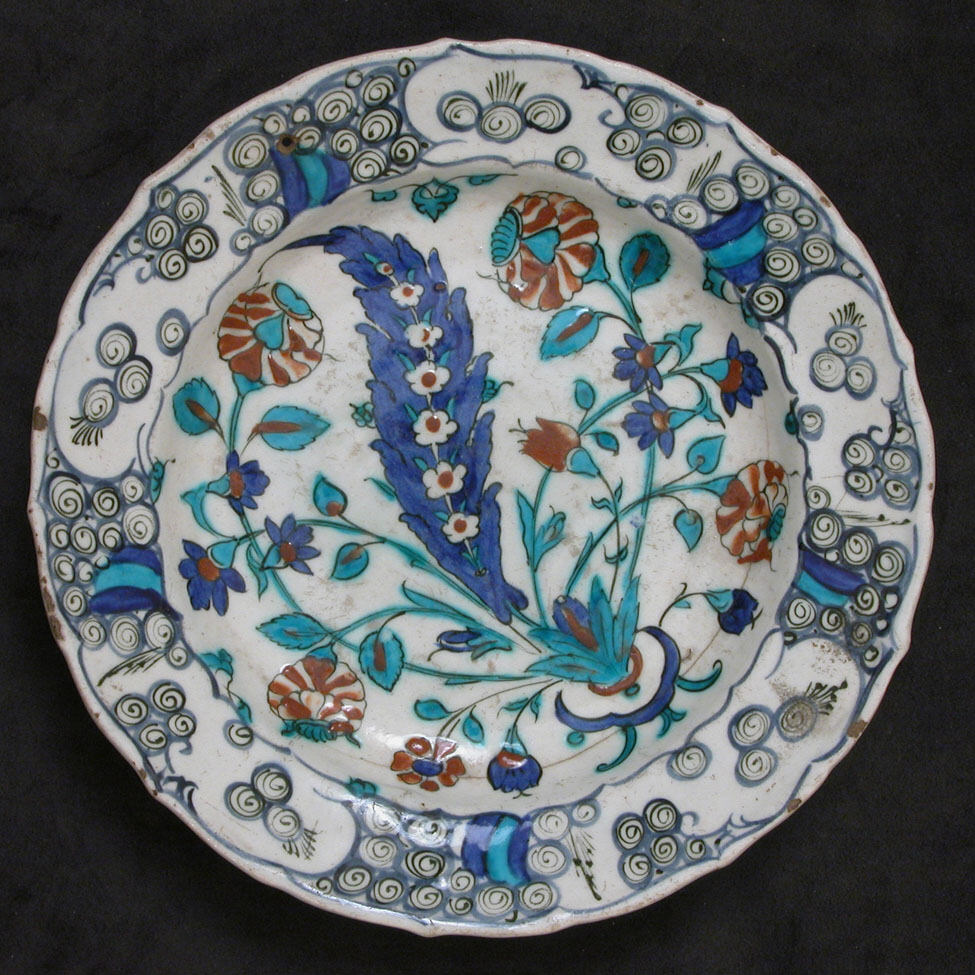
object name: dish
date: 1567-1600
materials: stonepaste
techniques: glazing, painting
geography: turkey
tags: flowers,leaves